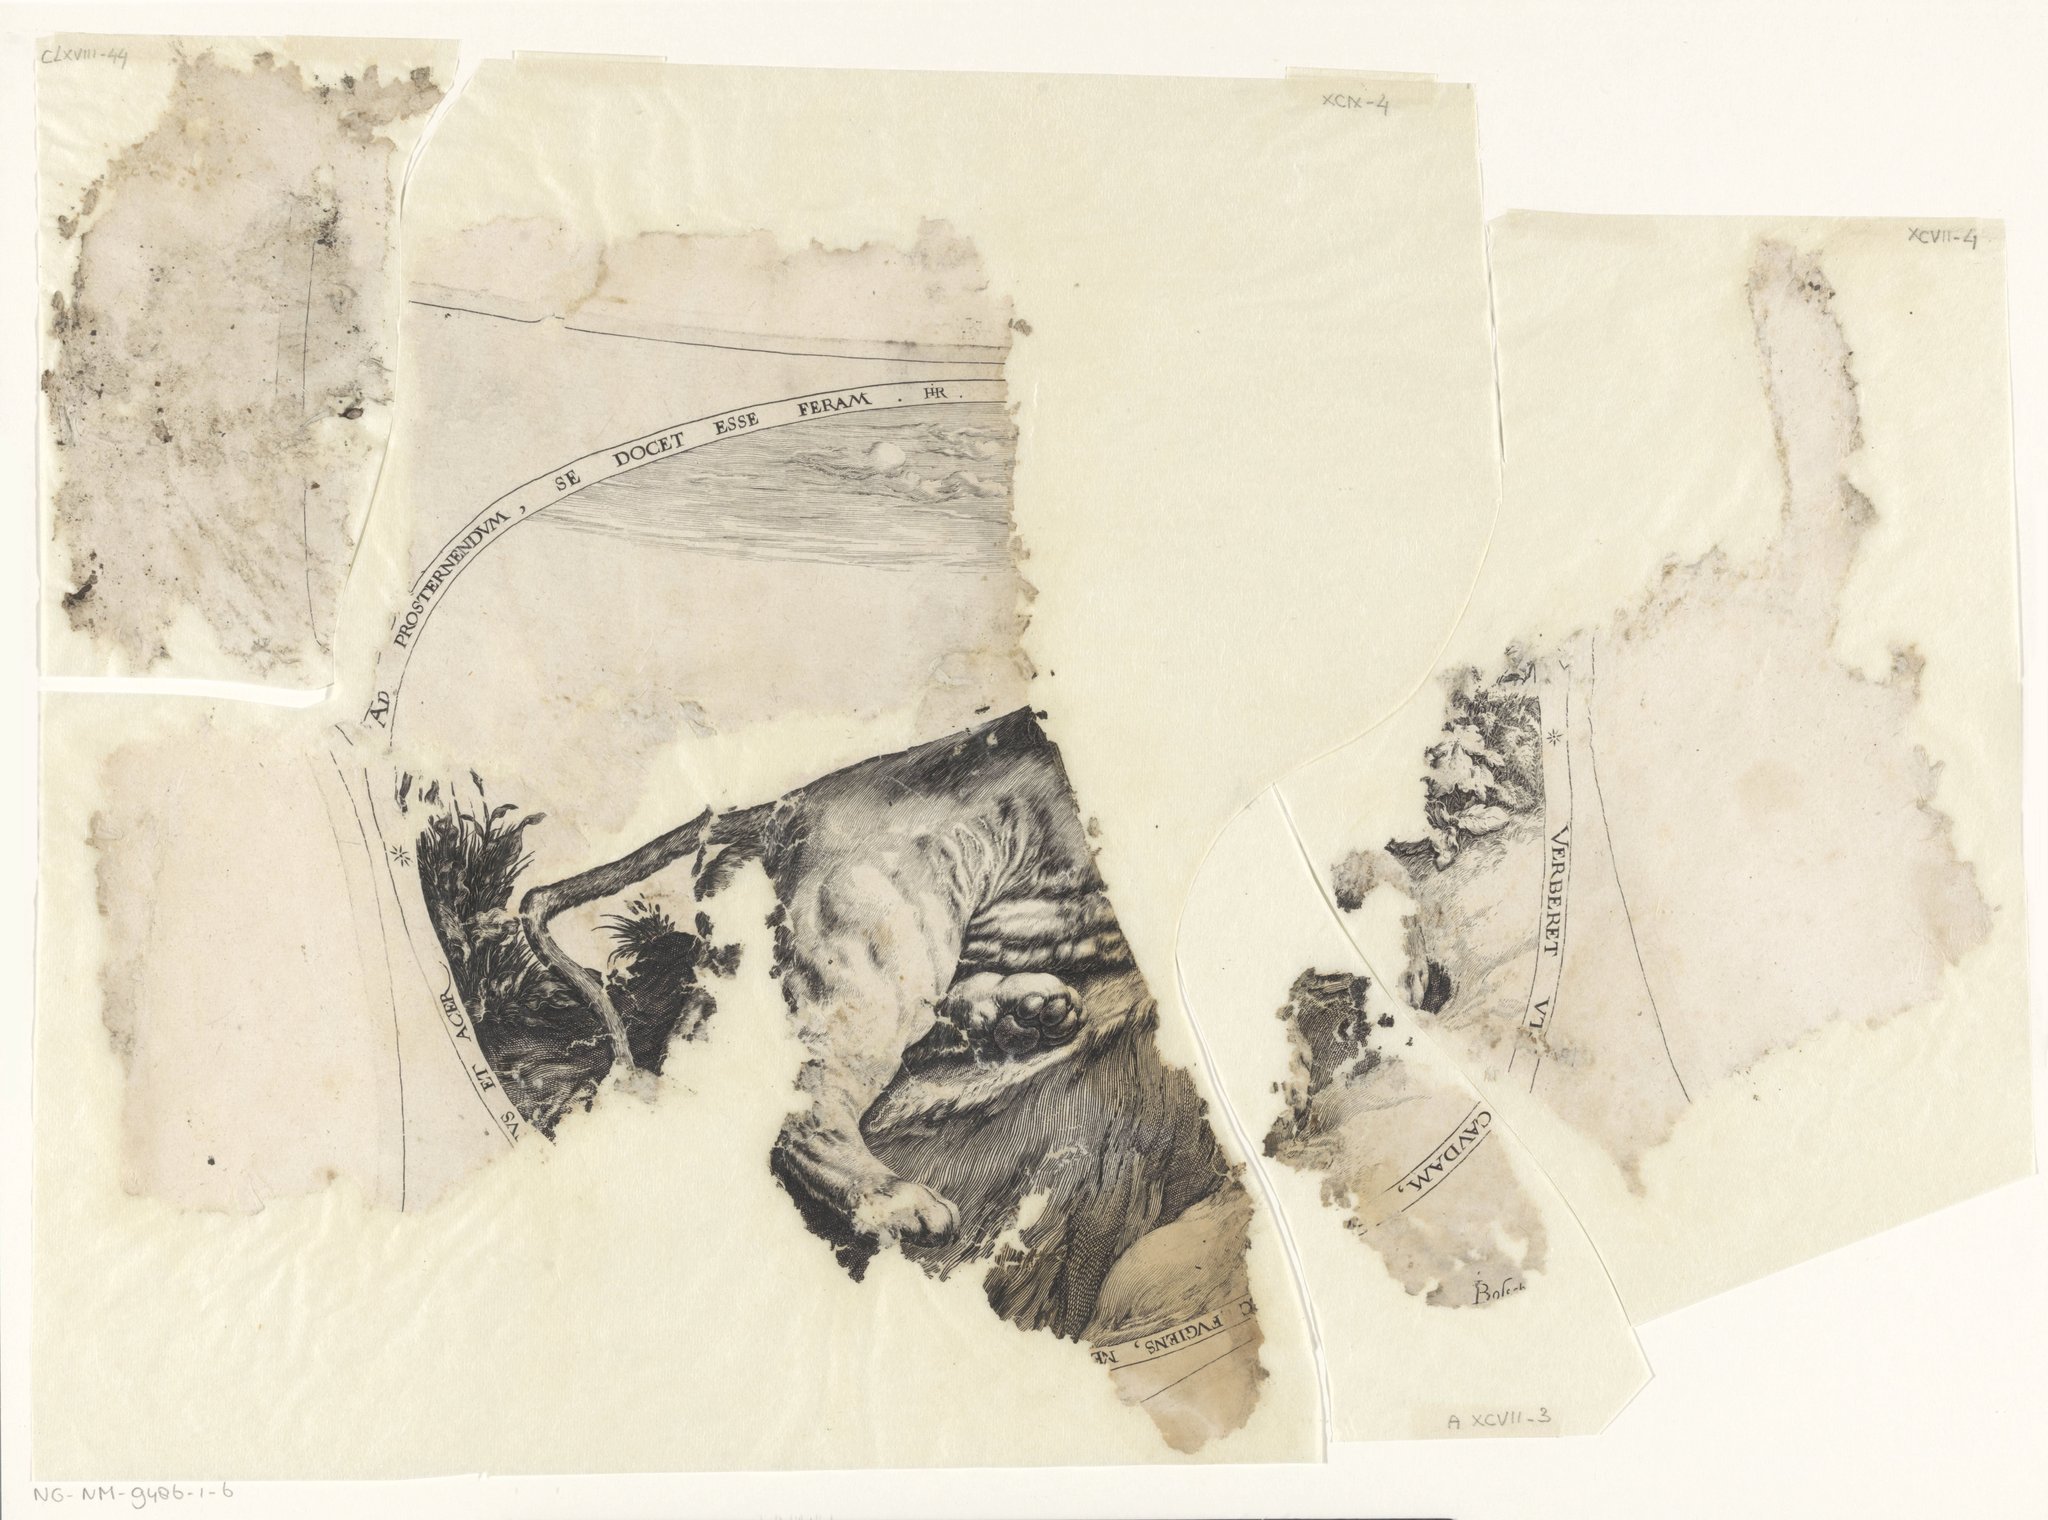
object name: print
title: Leeuw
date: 1580-1596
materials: paper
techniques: engraving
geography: northern netherlands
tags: beasts of prey, predatory animals: lion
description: De prenten in de Nova Zembla collectie zijn tijdens een expeditie van Willem Barendsz en Jacob van Heemskerk in 1596-1597 noodgedwongen in het winterkamp, het ‘Behouden Huis’, op het eiland achtergelaten. De prenten waren in één of meerdere stapels als handelswaar meegenomen vanuit Amsterdam. Bijna drie eeuwen later, in 1871, keerde de Noor Elling Carlsen terug naar Nova Zembla en vond daar de restanten van het ‘Behouden Huis, inclusief een groot deel van de inventaris. Een deel van de prenten, in de vorm van aaneengekoekte kluiten, werd toen ook teruggevonden. De papierkluiten waren soms op meerdere plekken gebroken. Tussen 1975-1979 zijn de prenten van elkaar gescheiden. Dit leverde in totaal ca. 1000 fragmenten van ca. 400 afdrukken van ca. 150 verschillende prenten op. Voor zover mogelijk zijn de fragmenten samengevoegd en zijn de prenten gereconstrueerd.